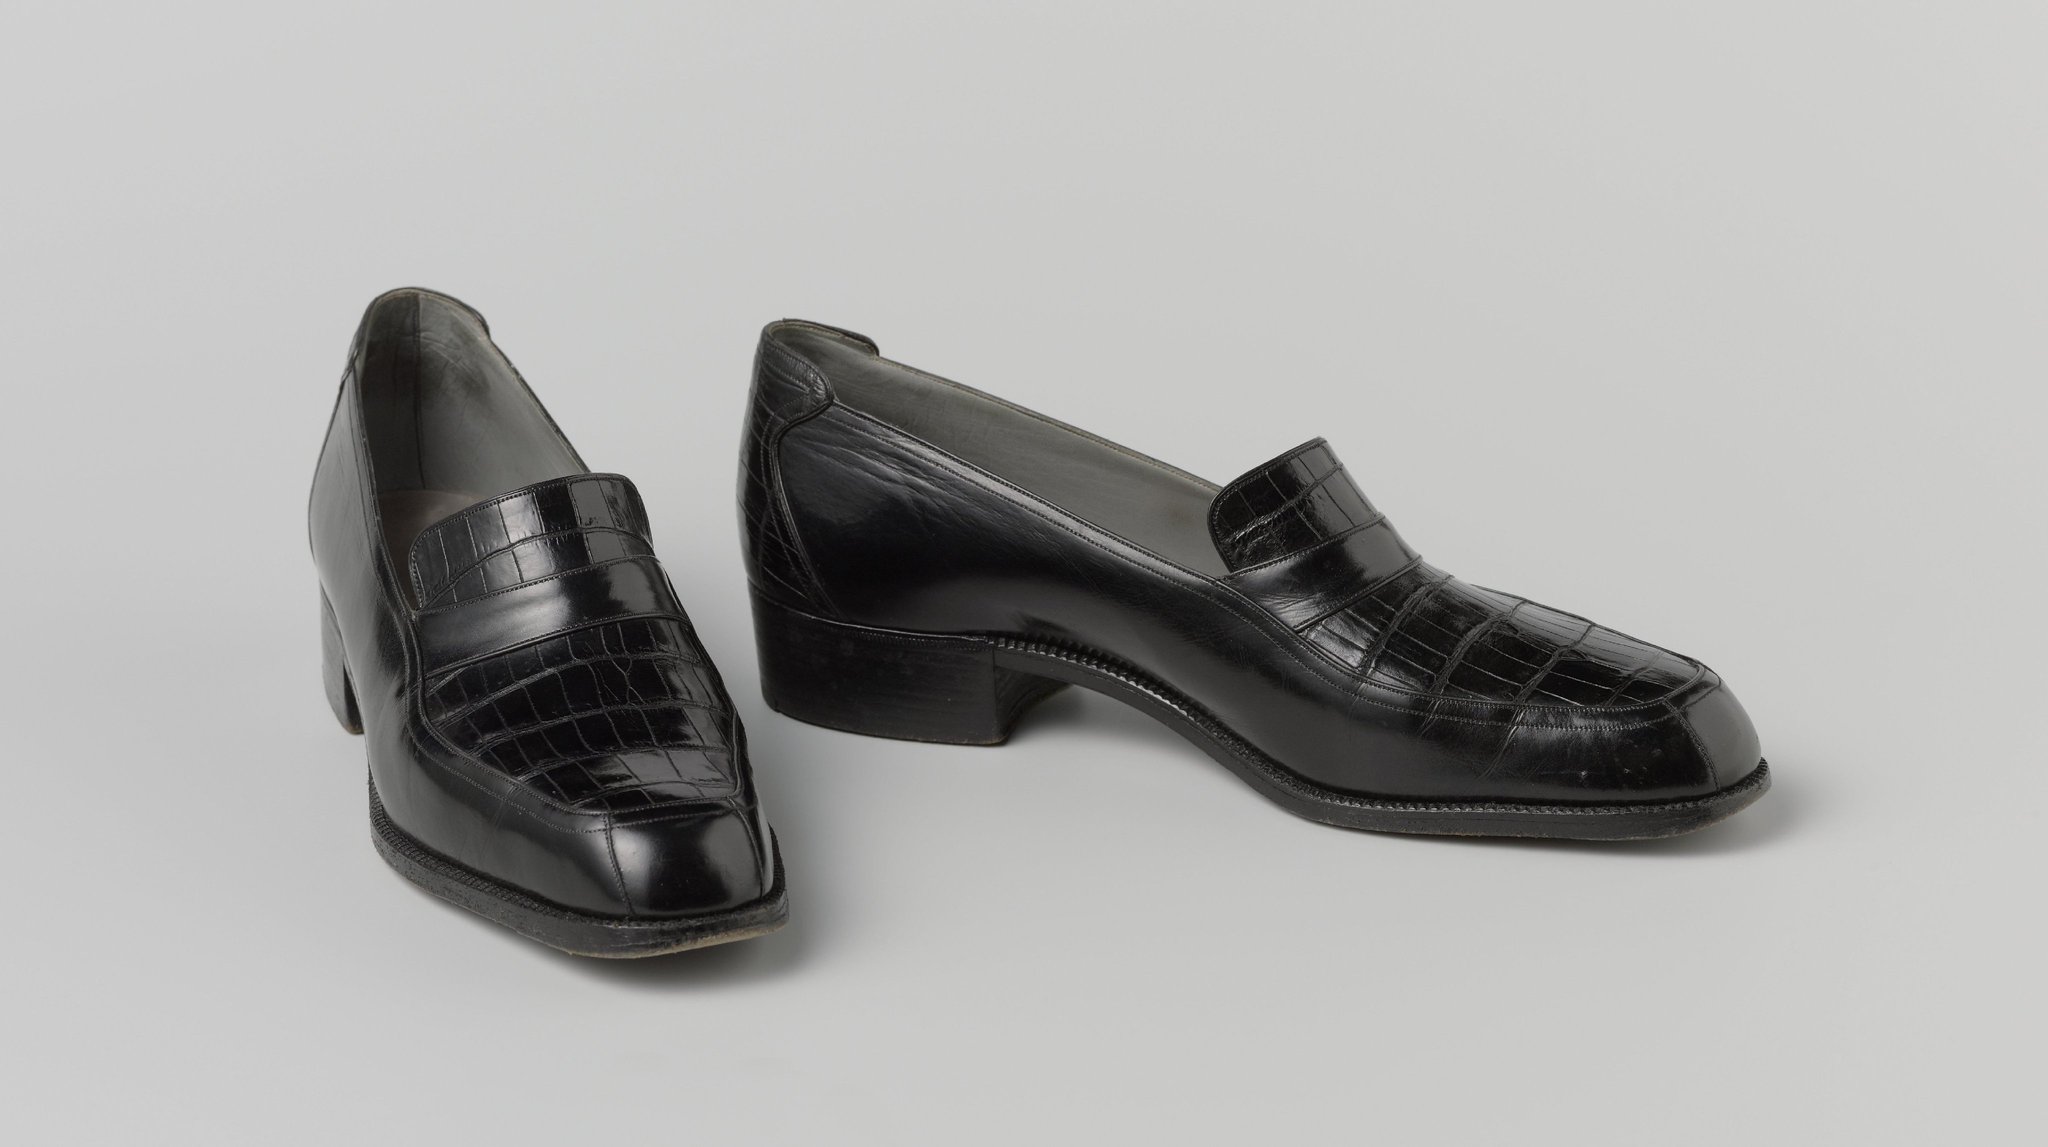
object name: shoe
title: Pair of Slip-Ons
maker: a. van goethem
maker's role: schoenmaker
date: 1960-1970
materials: leather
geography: brussels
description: Rechterinstapper van zwart leer met een tong van zwart krokodillenleer. Model met rechte neus en platte hak. Zijpanden van zwart leer lopen door tot aan de neus, die twee naden heeft. Onder de wreef over de tong een band van zwart leer. Grijze leren voering, behalve de tong op de wreef: zwart gevoerd. Binnenzool met gouden opdruk. Adres (op de binnenzool): A.VAN GOETHEM 15 RUE DE NAMUR/PRES LA PLACE ROYALE BRUXELLES.